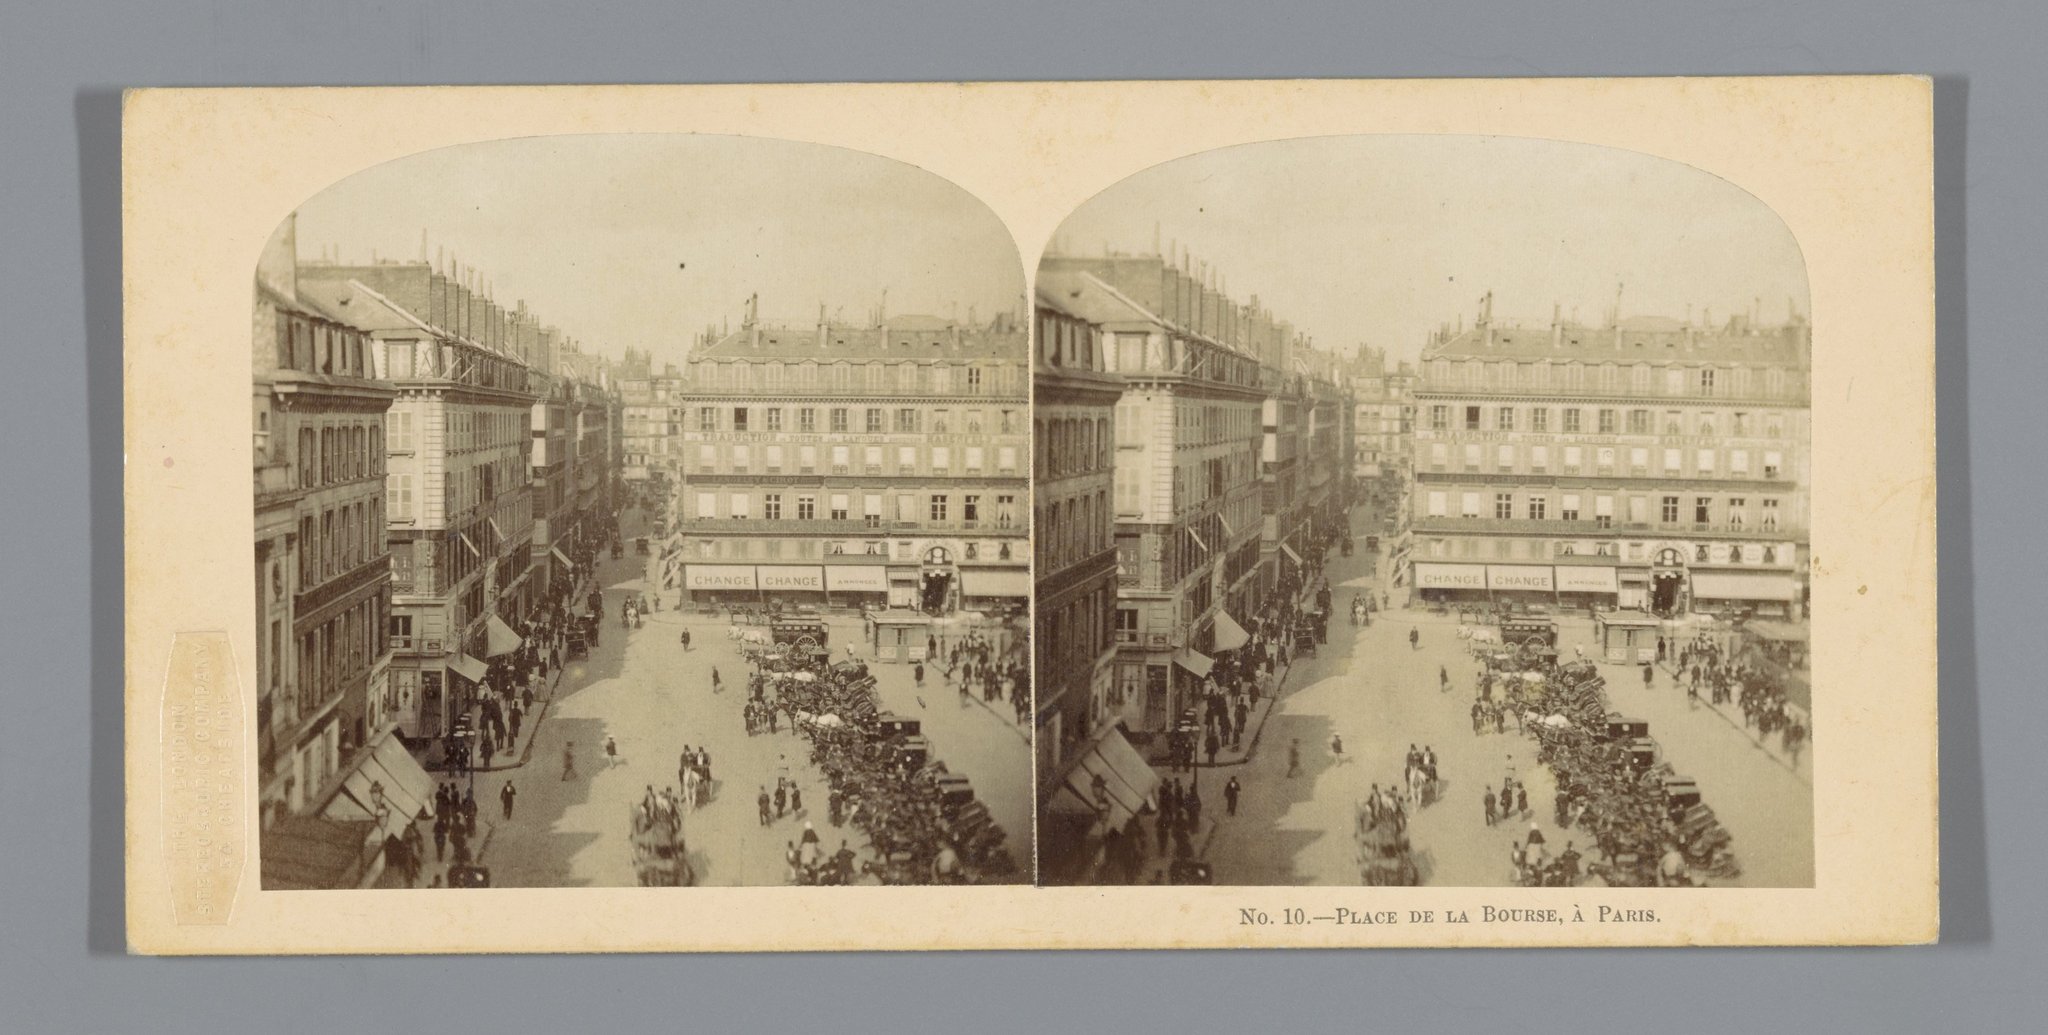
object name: stereograph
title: Place de la Bourse, à Paris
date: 1850-1875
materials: cardboard, photographic support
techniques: albumen print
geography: paris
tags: square, place, circus, etc.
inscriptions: number: ‘No. 10.’